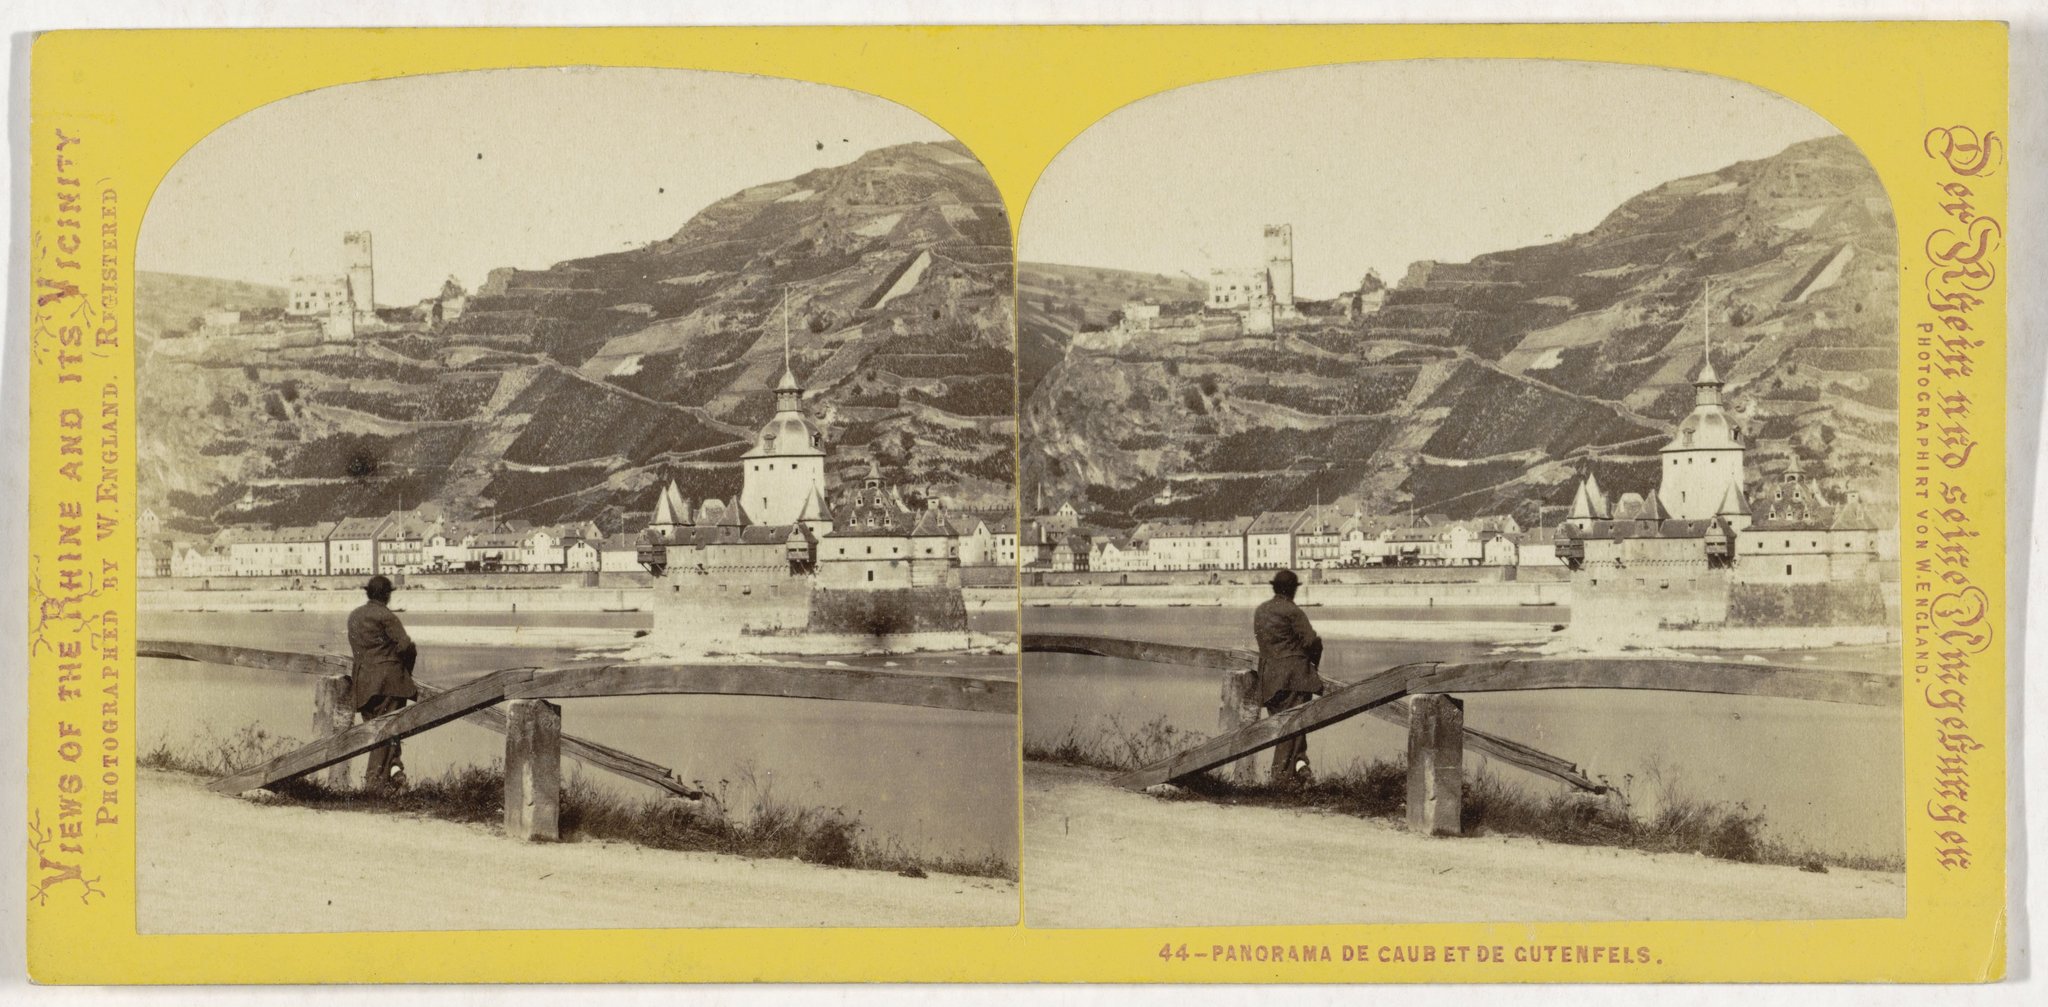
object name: stereograph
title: Views of the Rhine and its Vicinity / Der Rhein und seine Umgebungen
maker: william england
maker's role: fotograaf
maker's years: 1816-1896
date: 1867-1868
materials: cardboard, paper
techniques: albumen print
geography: kaub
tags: river, village, landscape with tower or castle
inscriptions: inscription: ‘(Registered)’, number: ‘44’